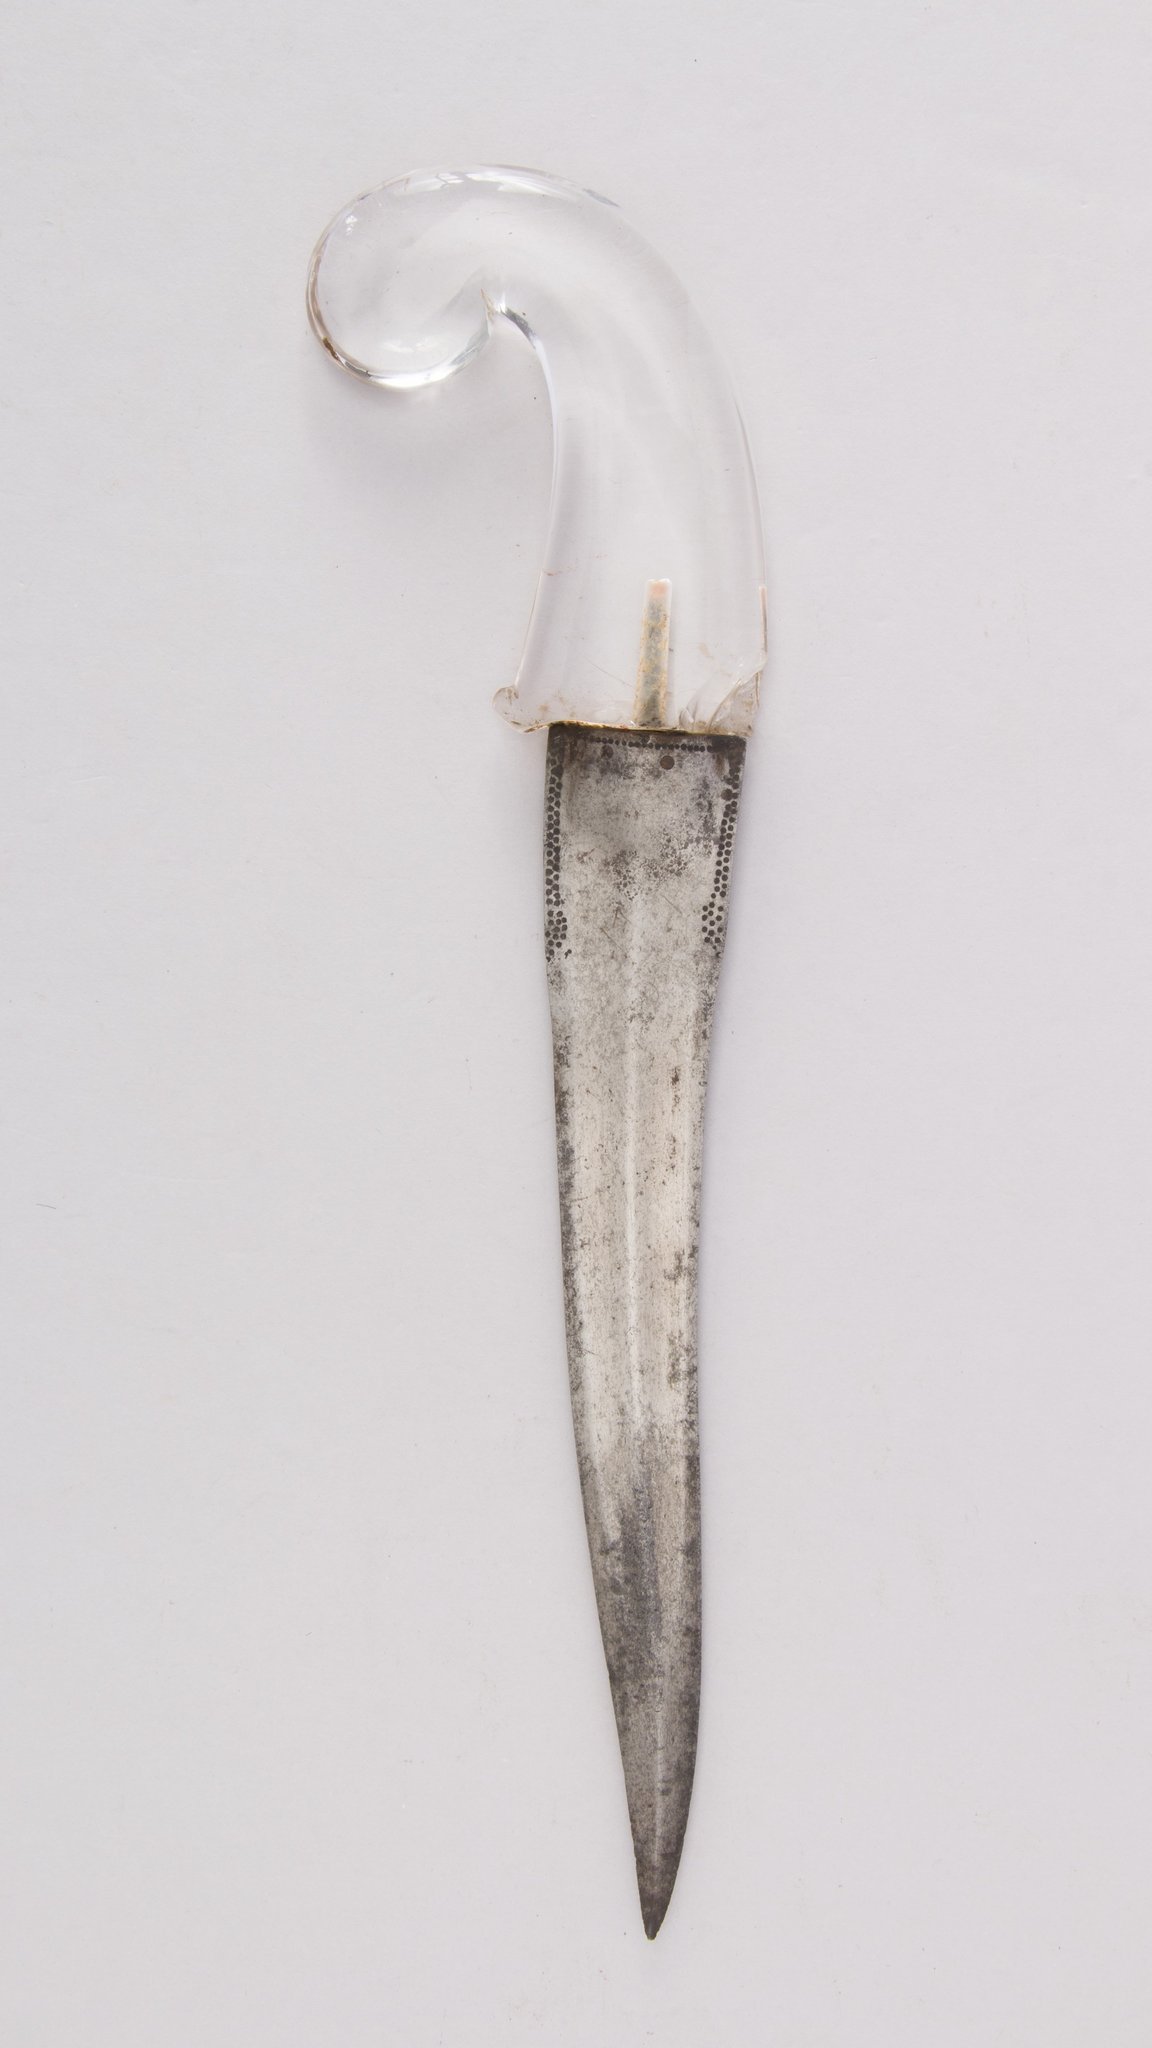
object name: dagger khanjar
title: Dagger (Khanjar)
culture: indian, mughal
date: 1801-1900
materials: quartz, steel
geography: india